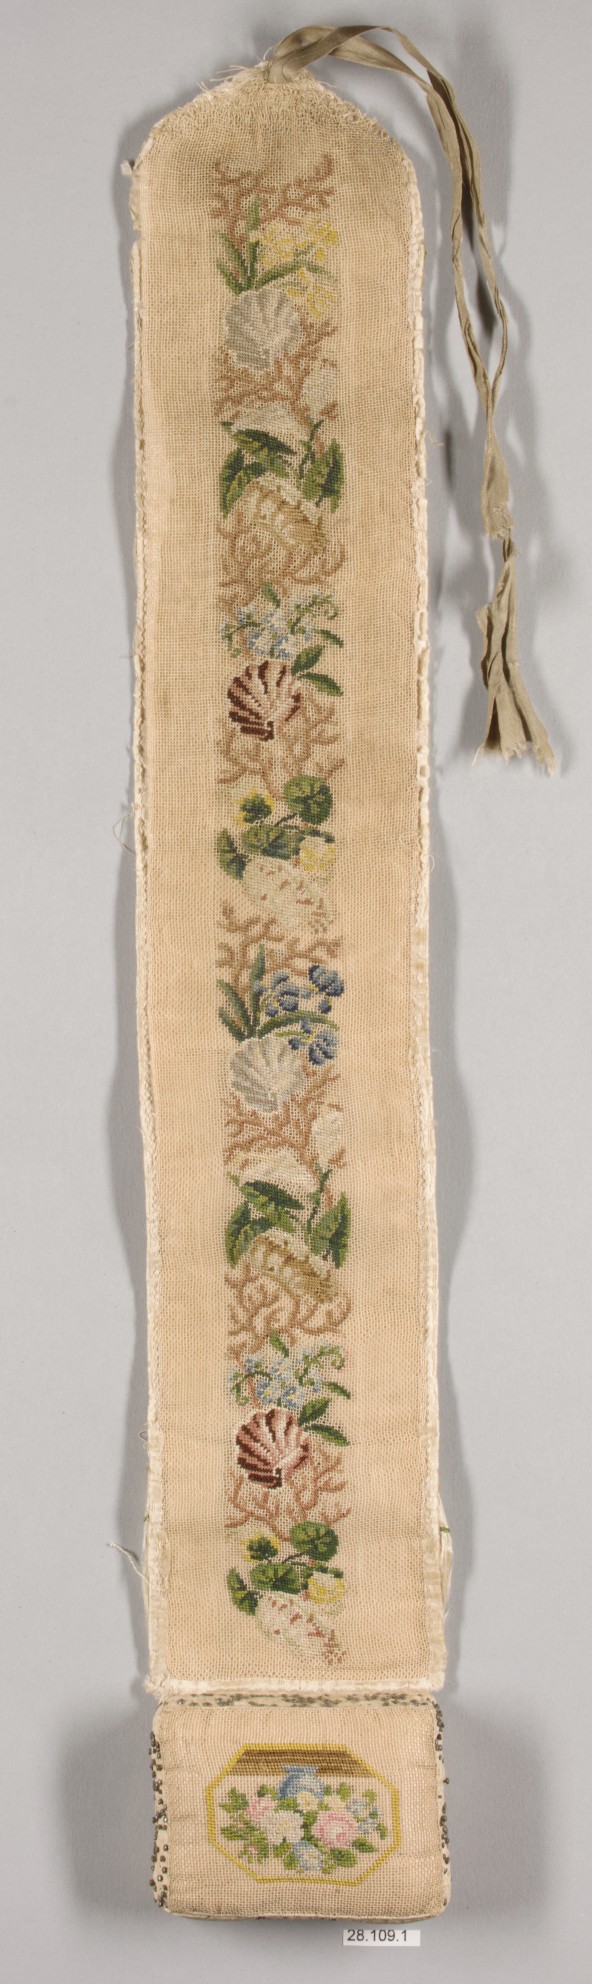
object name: needle case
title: Needlecase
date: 1805-1810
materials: canvas, silk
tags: flowers